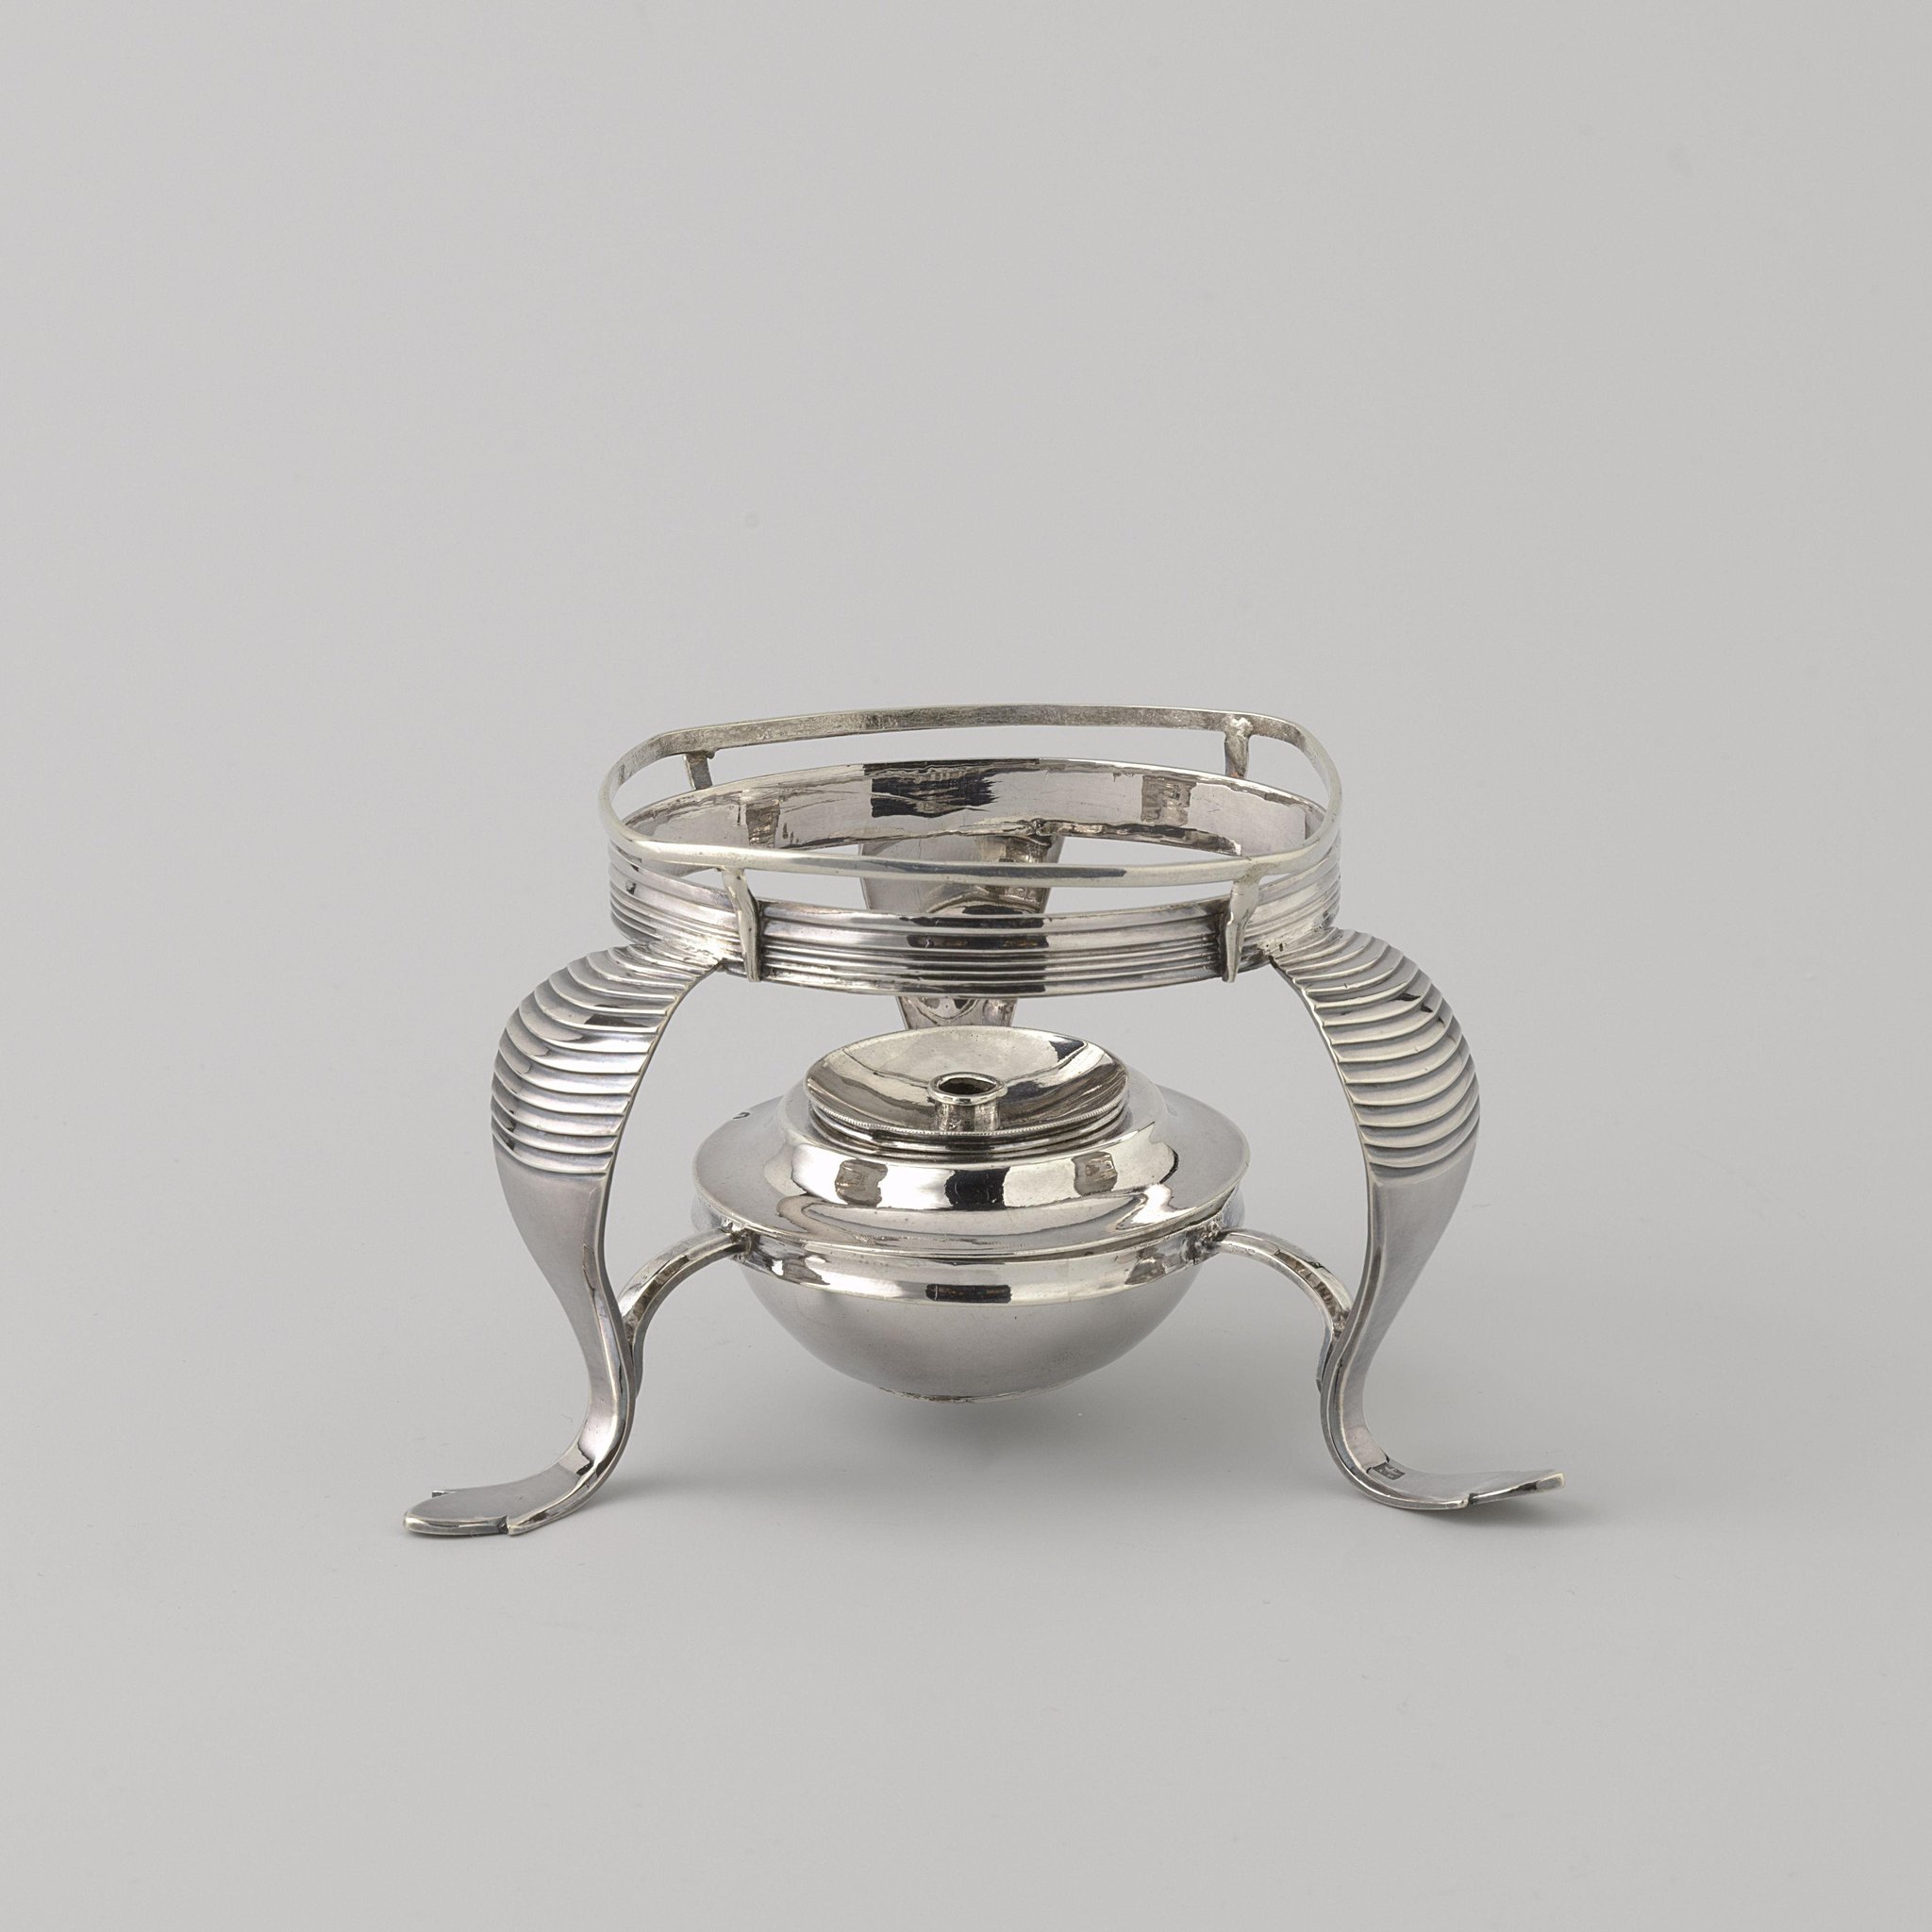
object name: burner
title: Brander, behorend bij komfoor, afgerond rechthoekig, geribd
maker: andreas roeloffs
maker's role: silversmith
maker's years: 1800-1862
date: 1843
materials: silver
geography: amsterdam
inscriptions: maker's mark, date letter, alloy mark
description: De afgerond rechthoekige standring van het komfoor (A) is met de brede, geribde, ovale bovenrand verbonden door middel van vier licht gebogen, spits toelopende stangetjes. De bovenrand rust op drie S-vormig gebogen poten waarvan het bovenste verbrede gedeelte geribd is. Vanaf de achterzijde van de poten rijzen drie gebogen verbindingsstukken op naar de ronde houder voor de losse brander (B). Deze bestaat uit een komvormig lichaam met een iets uitstekende, gewelfde, zich verjongende hals. De houder voor de lont past in een grote ronde opening in de bovenzijde.